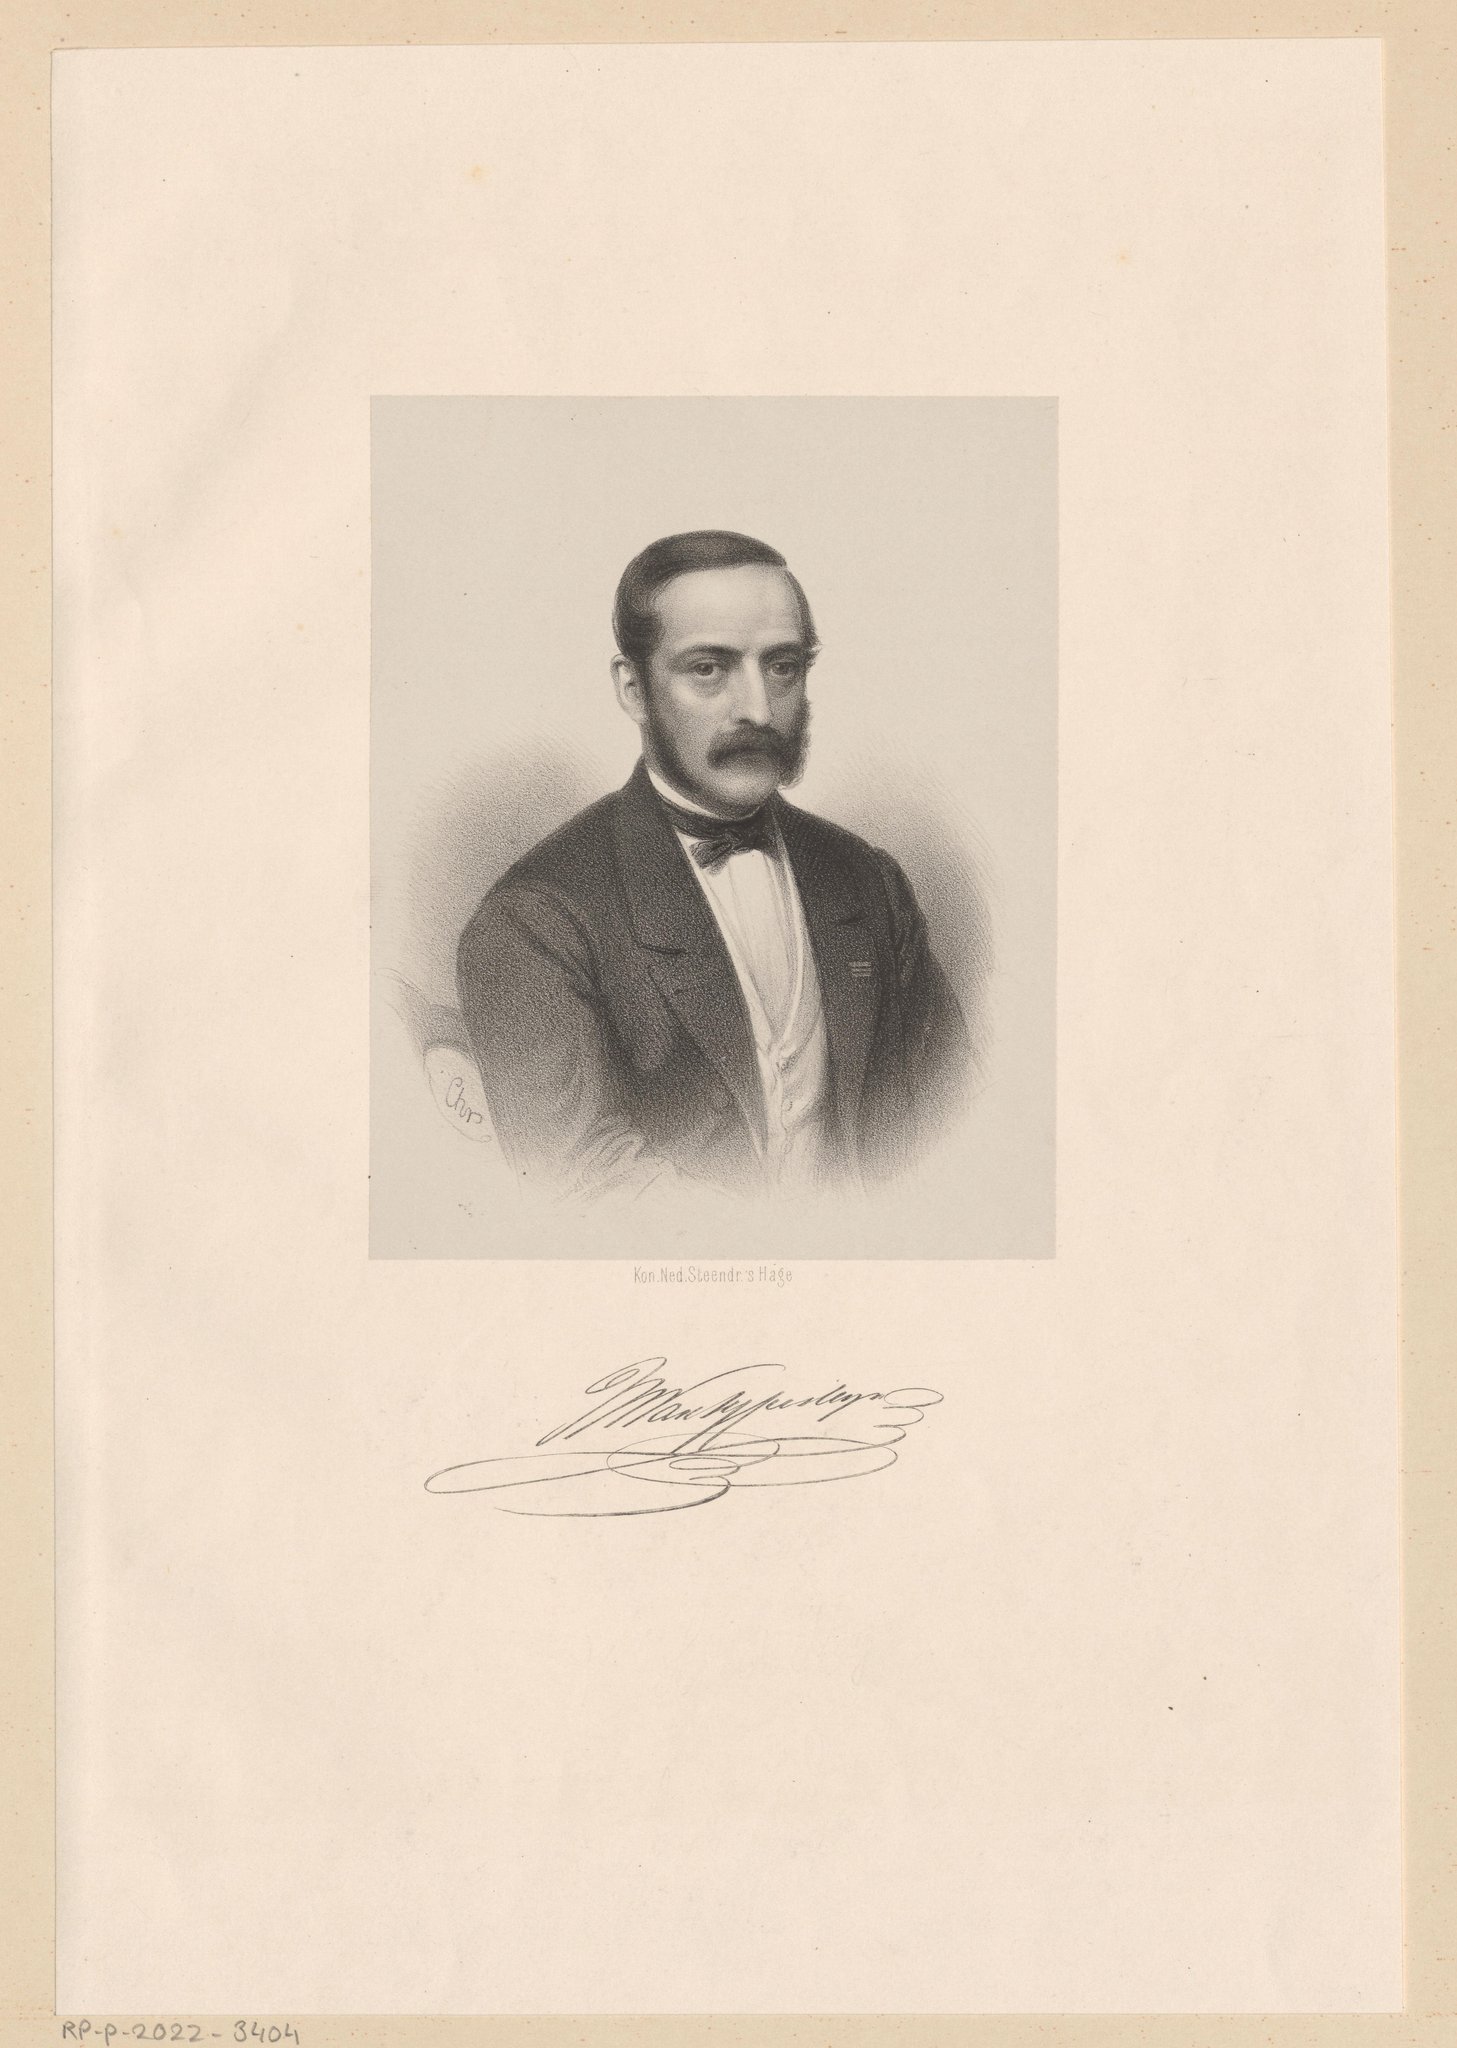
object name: print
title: Portret van Jan Willem van Sypesteyn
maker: wilhelmus cornelis chimaer van oudendorp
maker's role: print maker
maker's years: 1822-1873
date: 1867-1873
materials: paper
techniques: lithograph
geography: the hague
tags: the hague, historical persons, portrait of a writer